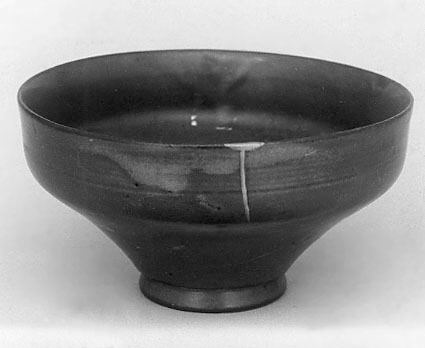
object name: teabowl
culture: japanese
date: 1701-1800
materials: clay, glaze